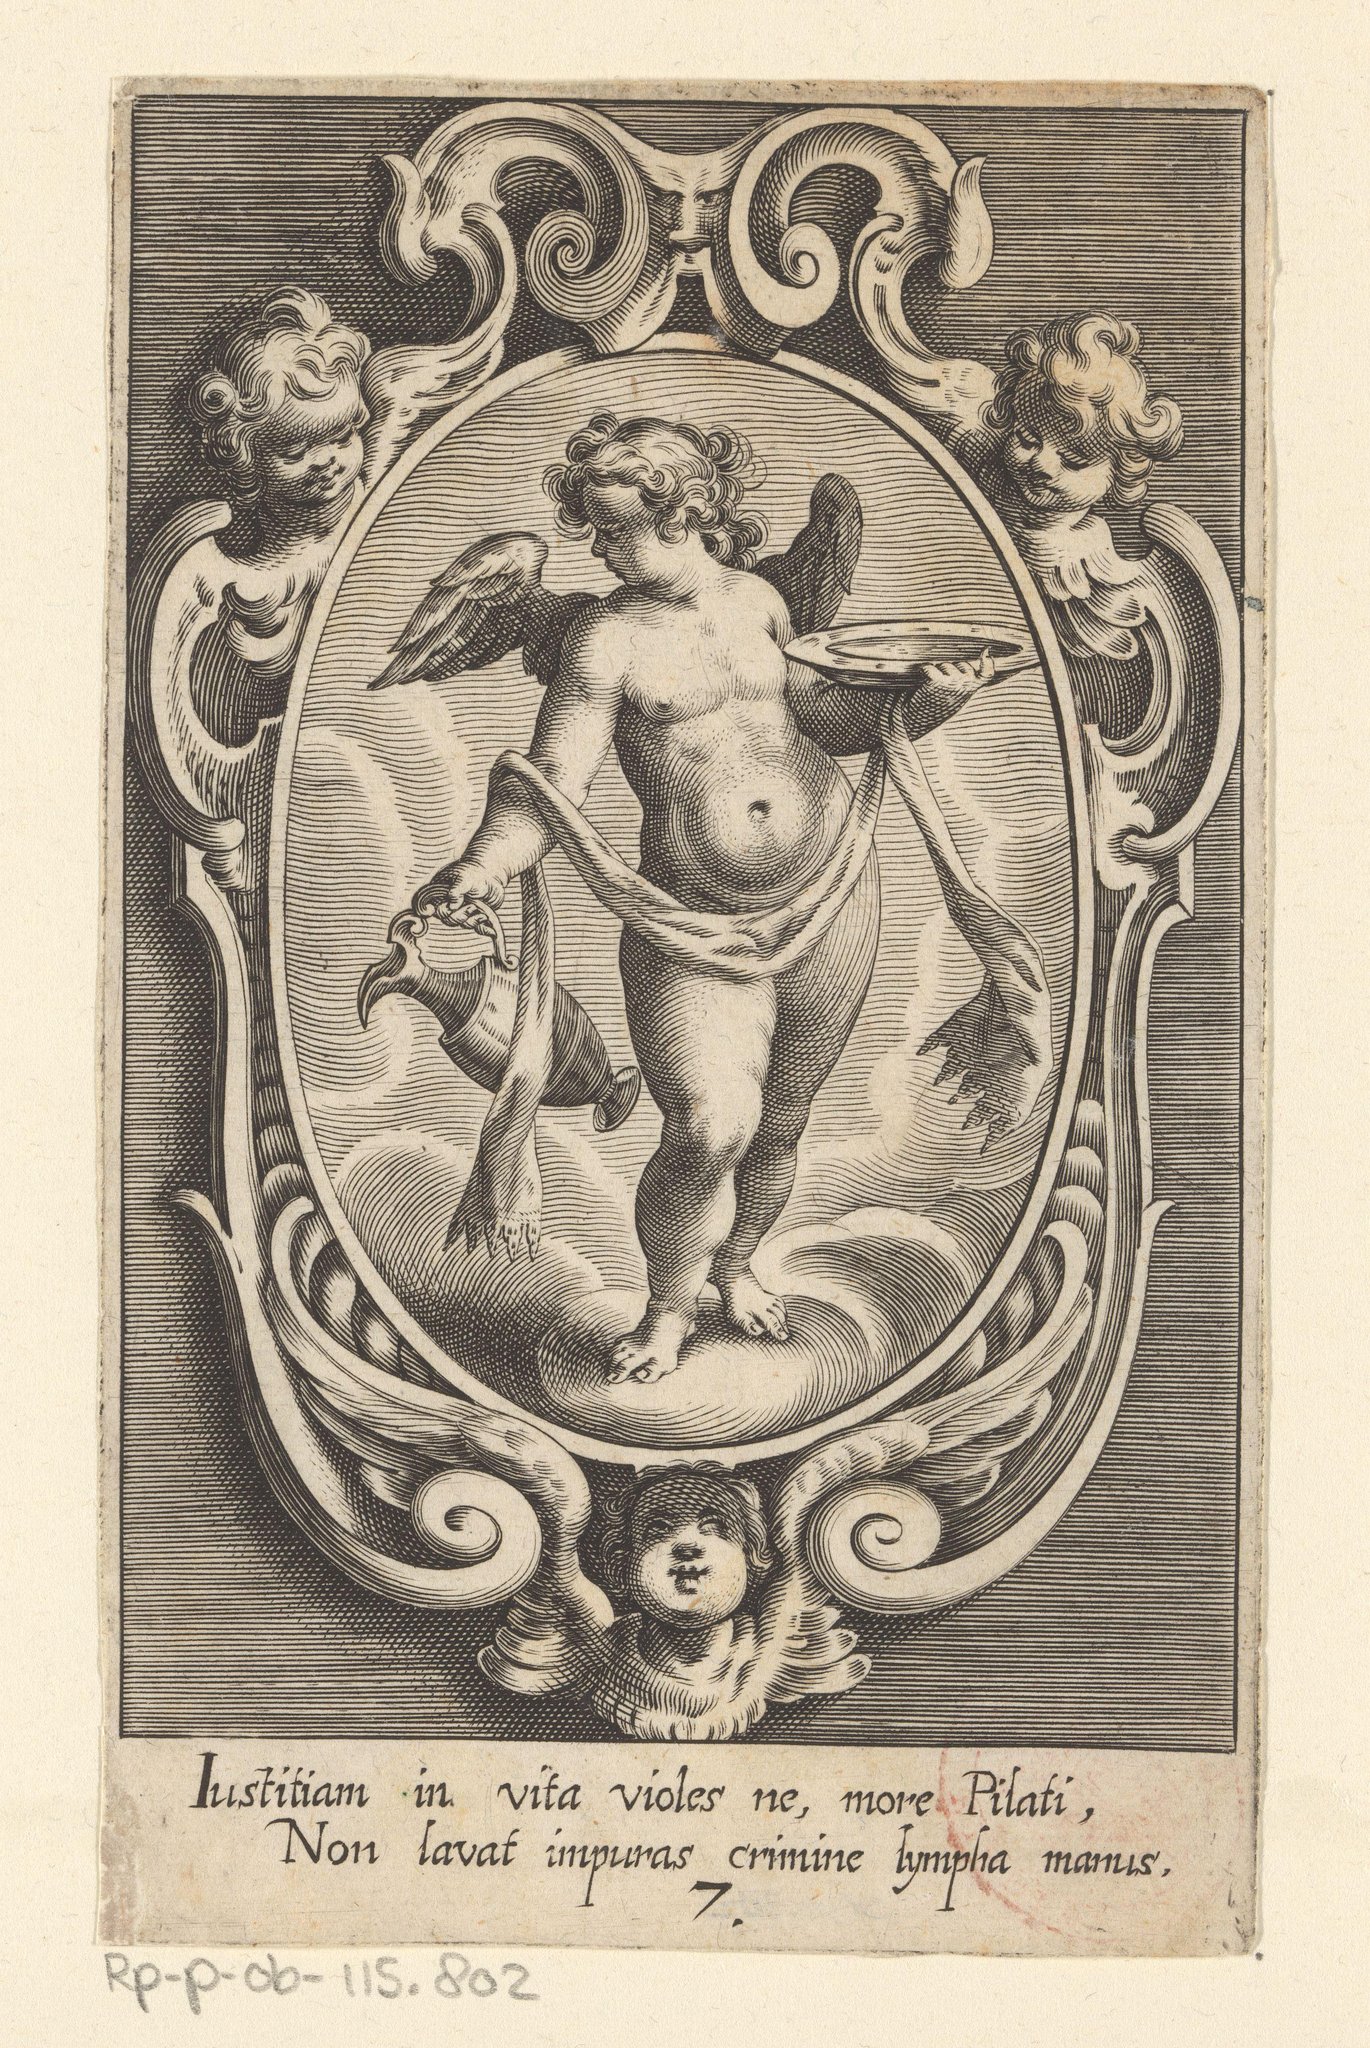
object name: print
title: Kan en schotel, gedragen door een engel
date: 1620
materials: paper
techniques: engraving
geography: augsburg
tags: single instruments of the passion (with name), 'arma christi', chalice, pilate washing his hands (in innocence)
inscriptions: collector's mark: Lugt 240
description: Serie bevattende een titelprent en elf prenten van de passiewerktuigen. De prenten zijn genummerd van één tot en met twaalf. Nummer tien is niet aanwezig in deze serie, evenals in de series genoemd in de referentielitertuur.